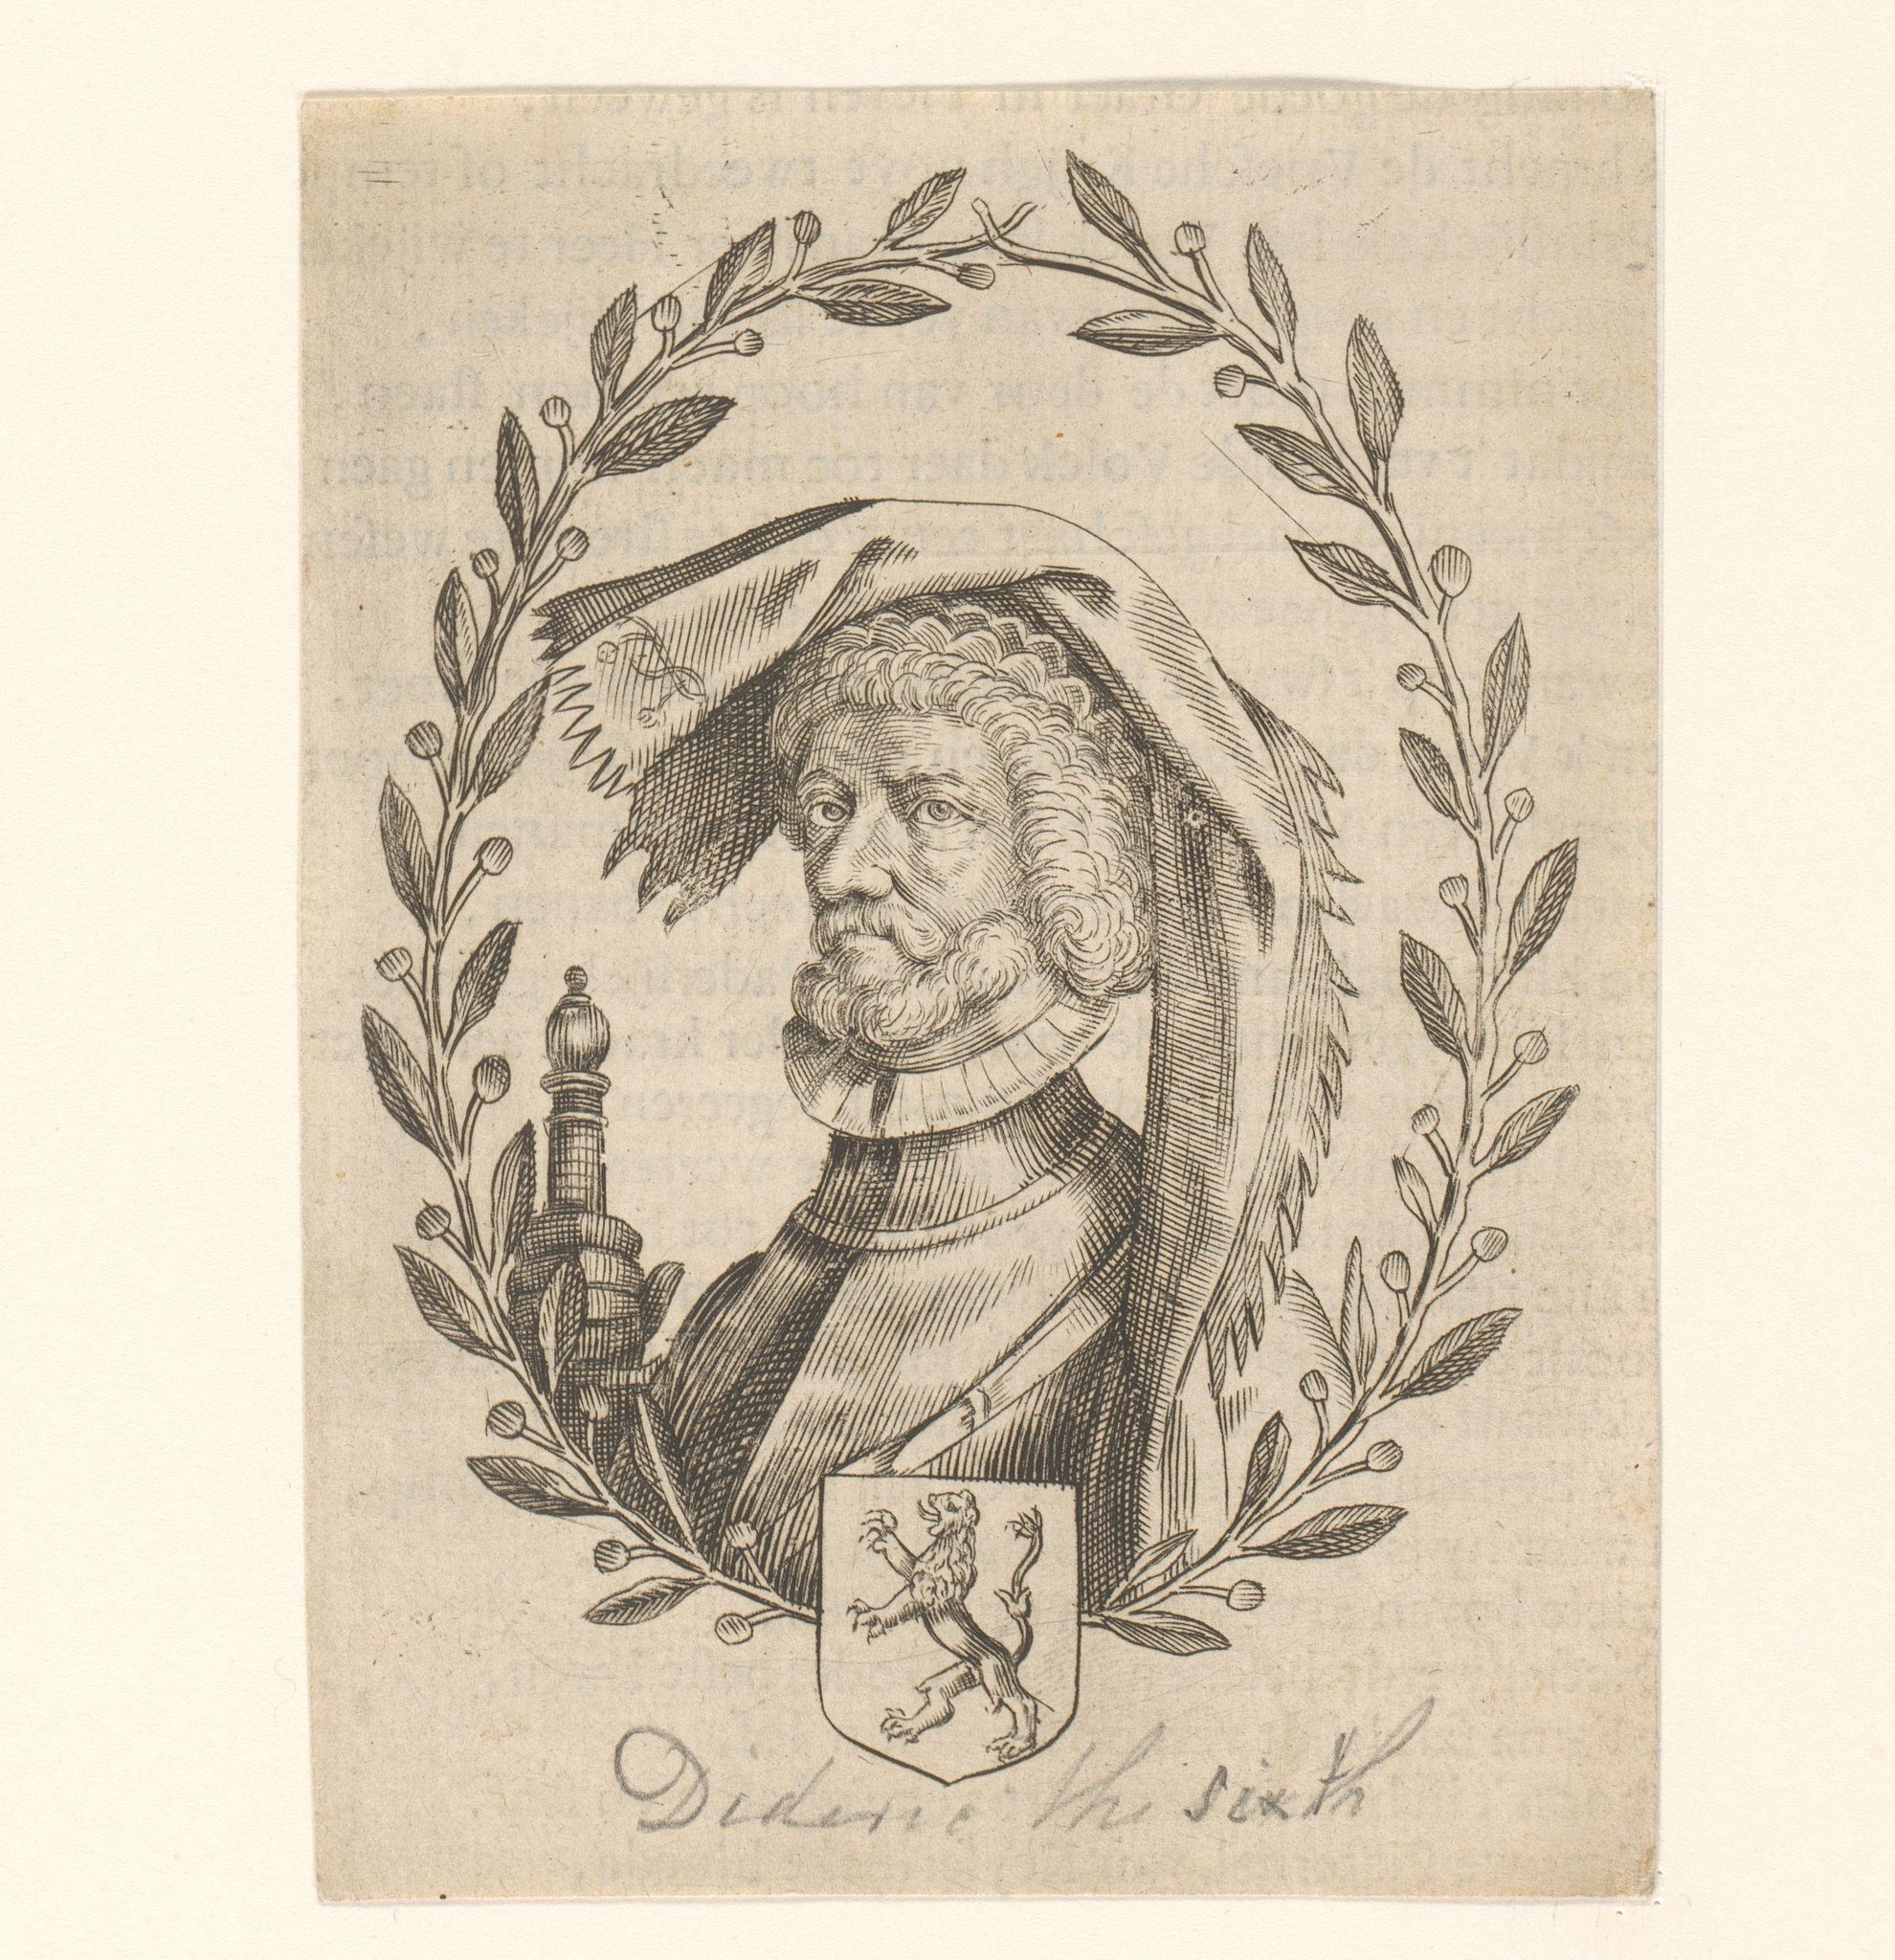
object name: book illustration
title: Portret van Dirk VI, graaf van Holland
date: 1645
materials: paper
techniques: engraving, letterpress printing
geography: amsterdam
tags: historical persons, ruler, sovereign, armorial bearing, heraldry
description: Prent uit: Wachtendorp, Caspar. Oude Hollandsche geschiedenissen ofte, korte Hollandtsche rym-kronyck. 14 dln. Amsterdam: Johannes Pauli, 1645.